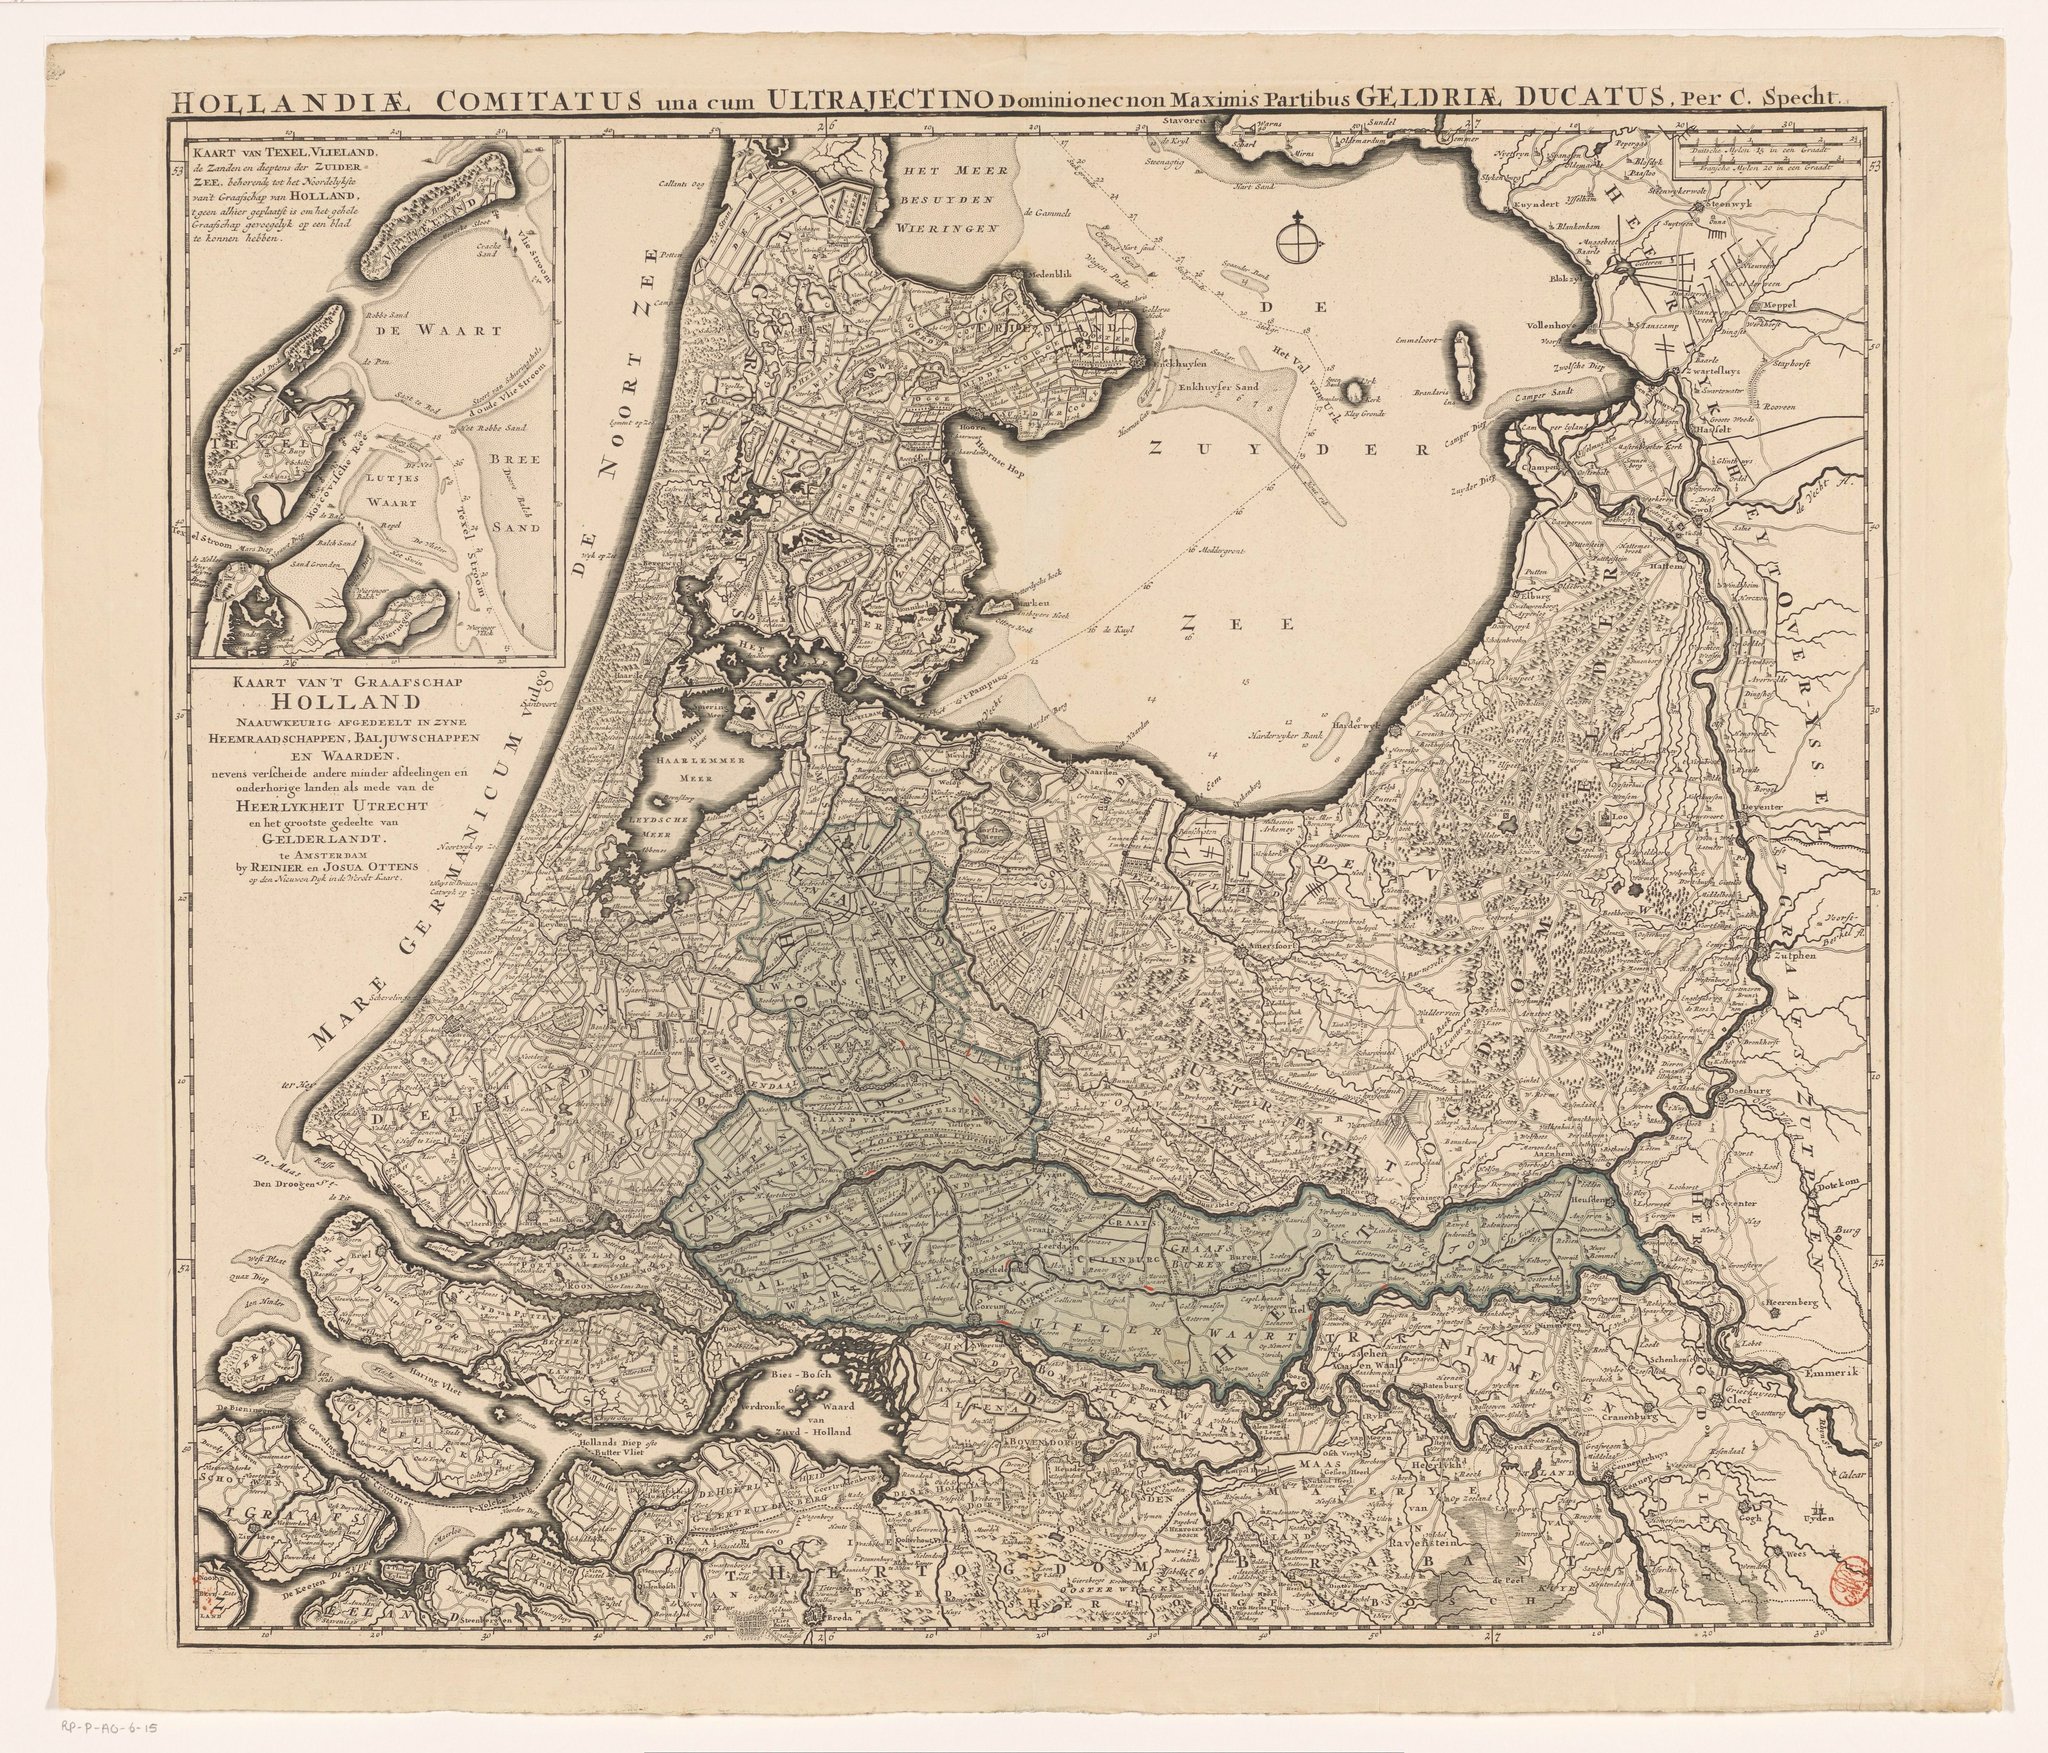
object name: map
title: Kaart van Holland, Utrecht en een deel van Gelderland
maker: caspar specht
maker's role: print maker, publisher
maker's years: 1654-1710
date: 1704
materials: paper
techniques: engraving, hand coloring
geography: amsterdam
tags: maps of separate countries or regions, gelderland, holland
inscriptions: collector's mark: Lugt 195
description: Kaart van het graafschap Holland, de heerlijkheid Utrecht en het grootste deel van het hertogdom Gelderland. Linksboven een inzetkaart van Texel en Vlieland. Daaronder de Nederlandse titel. Rechtsboven twee schaalstokken: Duitsche mylen 15 in een graadt; Fransche mylen 20 in een graadt. Gradenverdeling langs de randen.